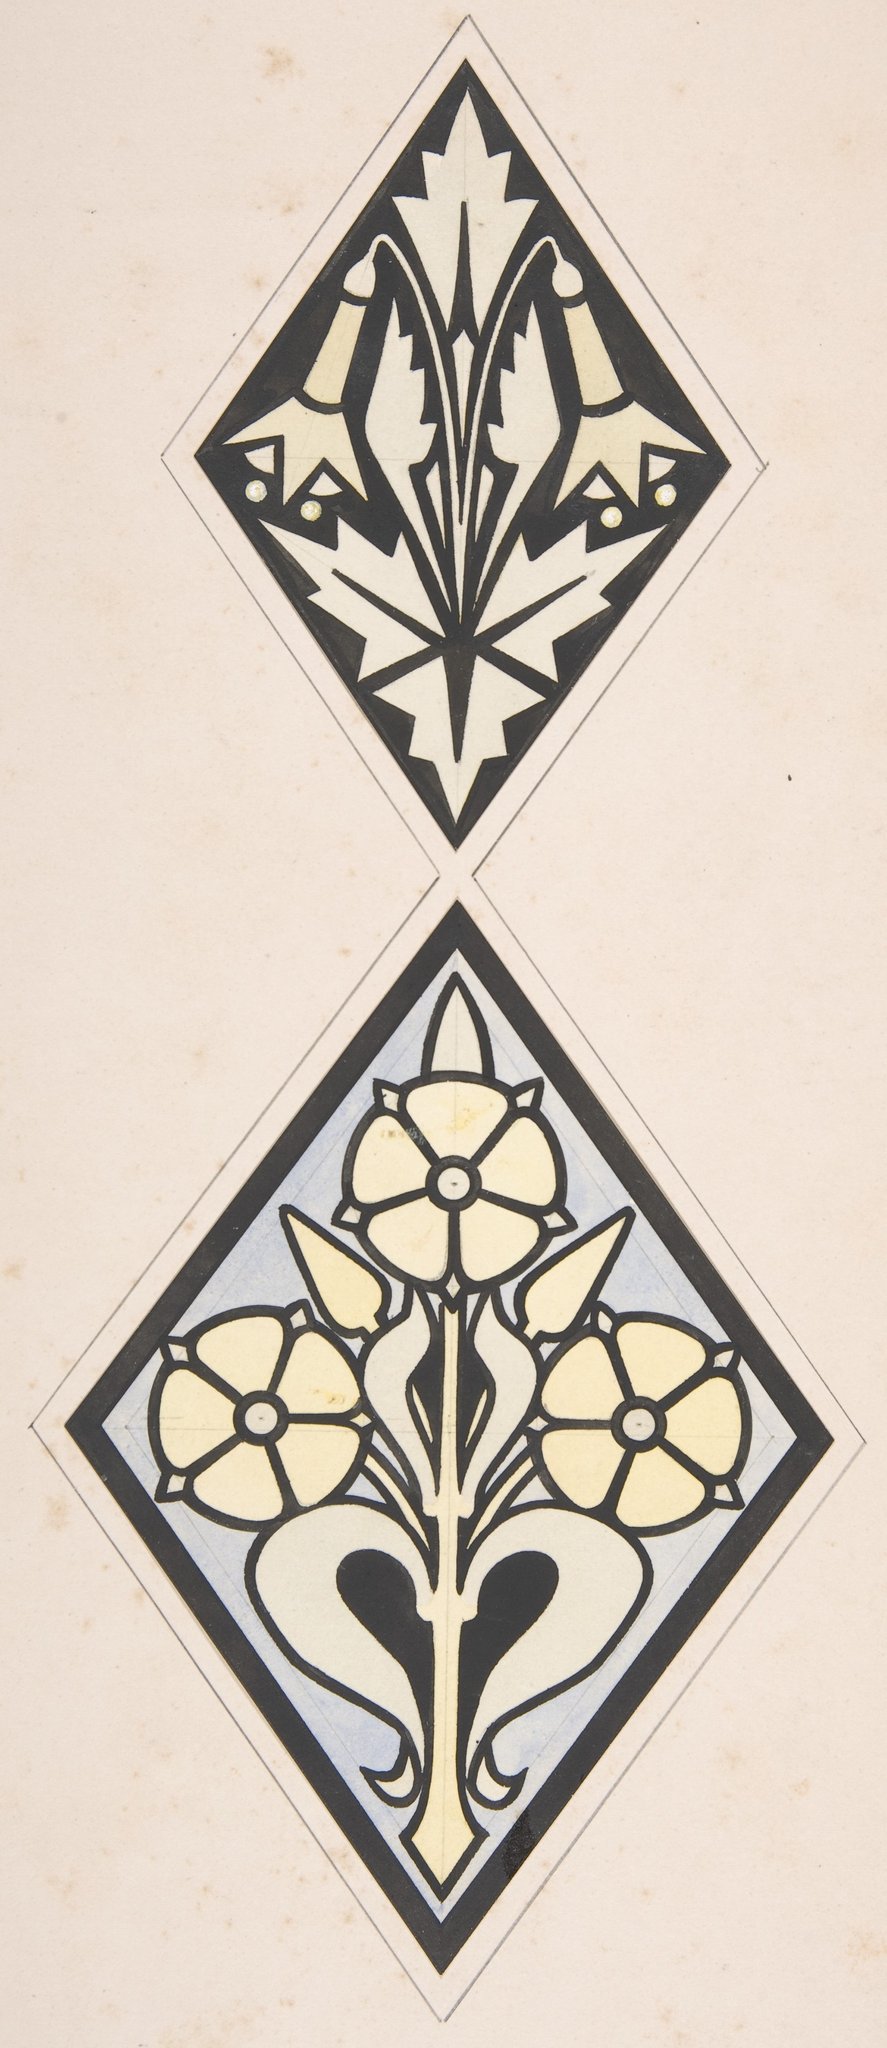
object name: drawing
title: Design drawing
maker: christopher dresser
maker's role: designer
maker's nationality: british, scottish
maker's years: 1834-1904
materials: gouache, graphite, ink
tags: ornament